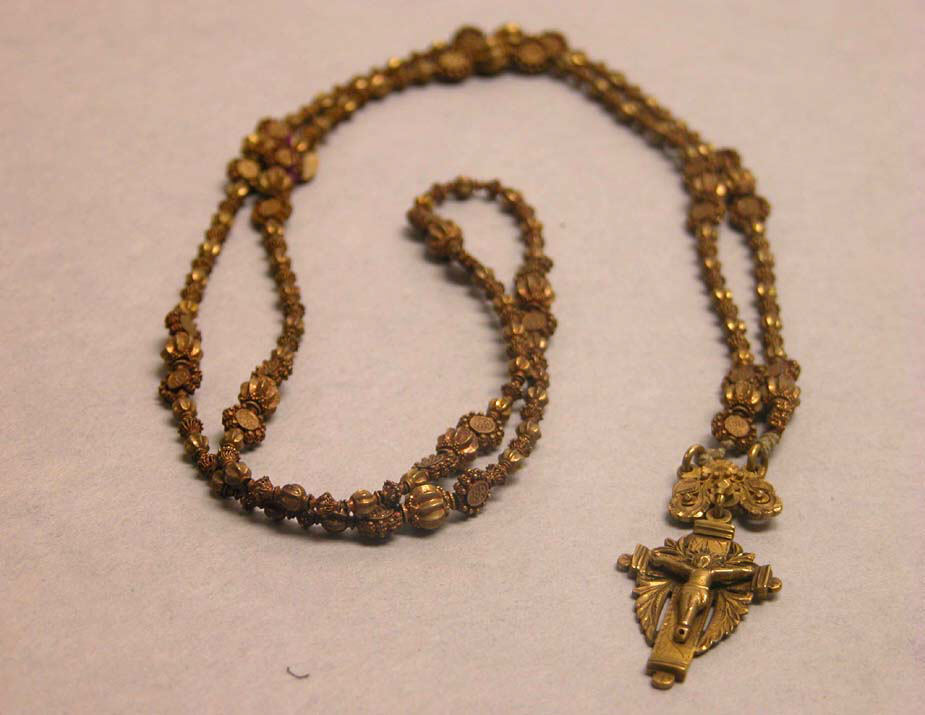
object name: rosary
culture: filipino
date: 1601-1900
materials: gold